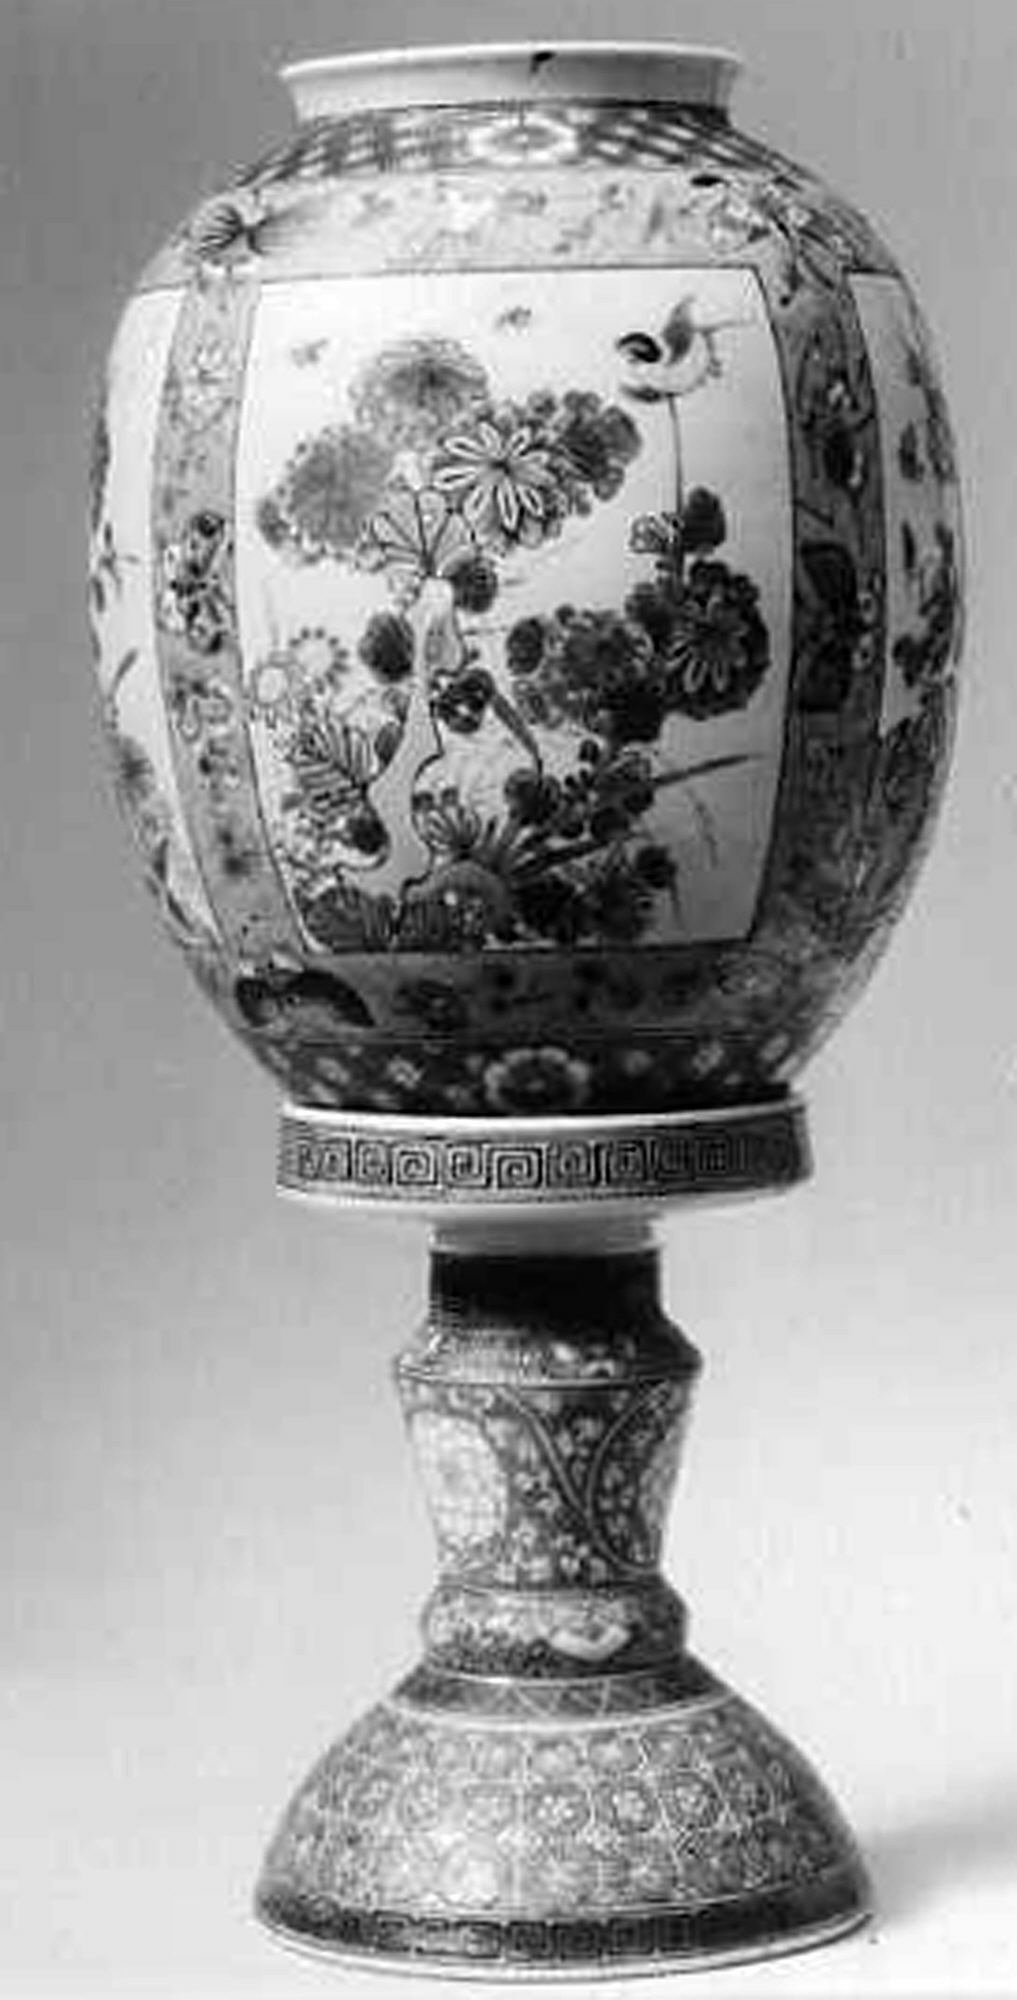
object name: lantern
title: Lantern (one of a pair)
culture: chinese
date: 1723-1735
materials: enamel, porcelain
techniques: painting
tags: birds,flowers